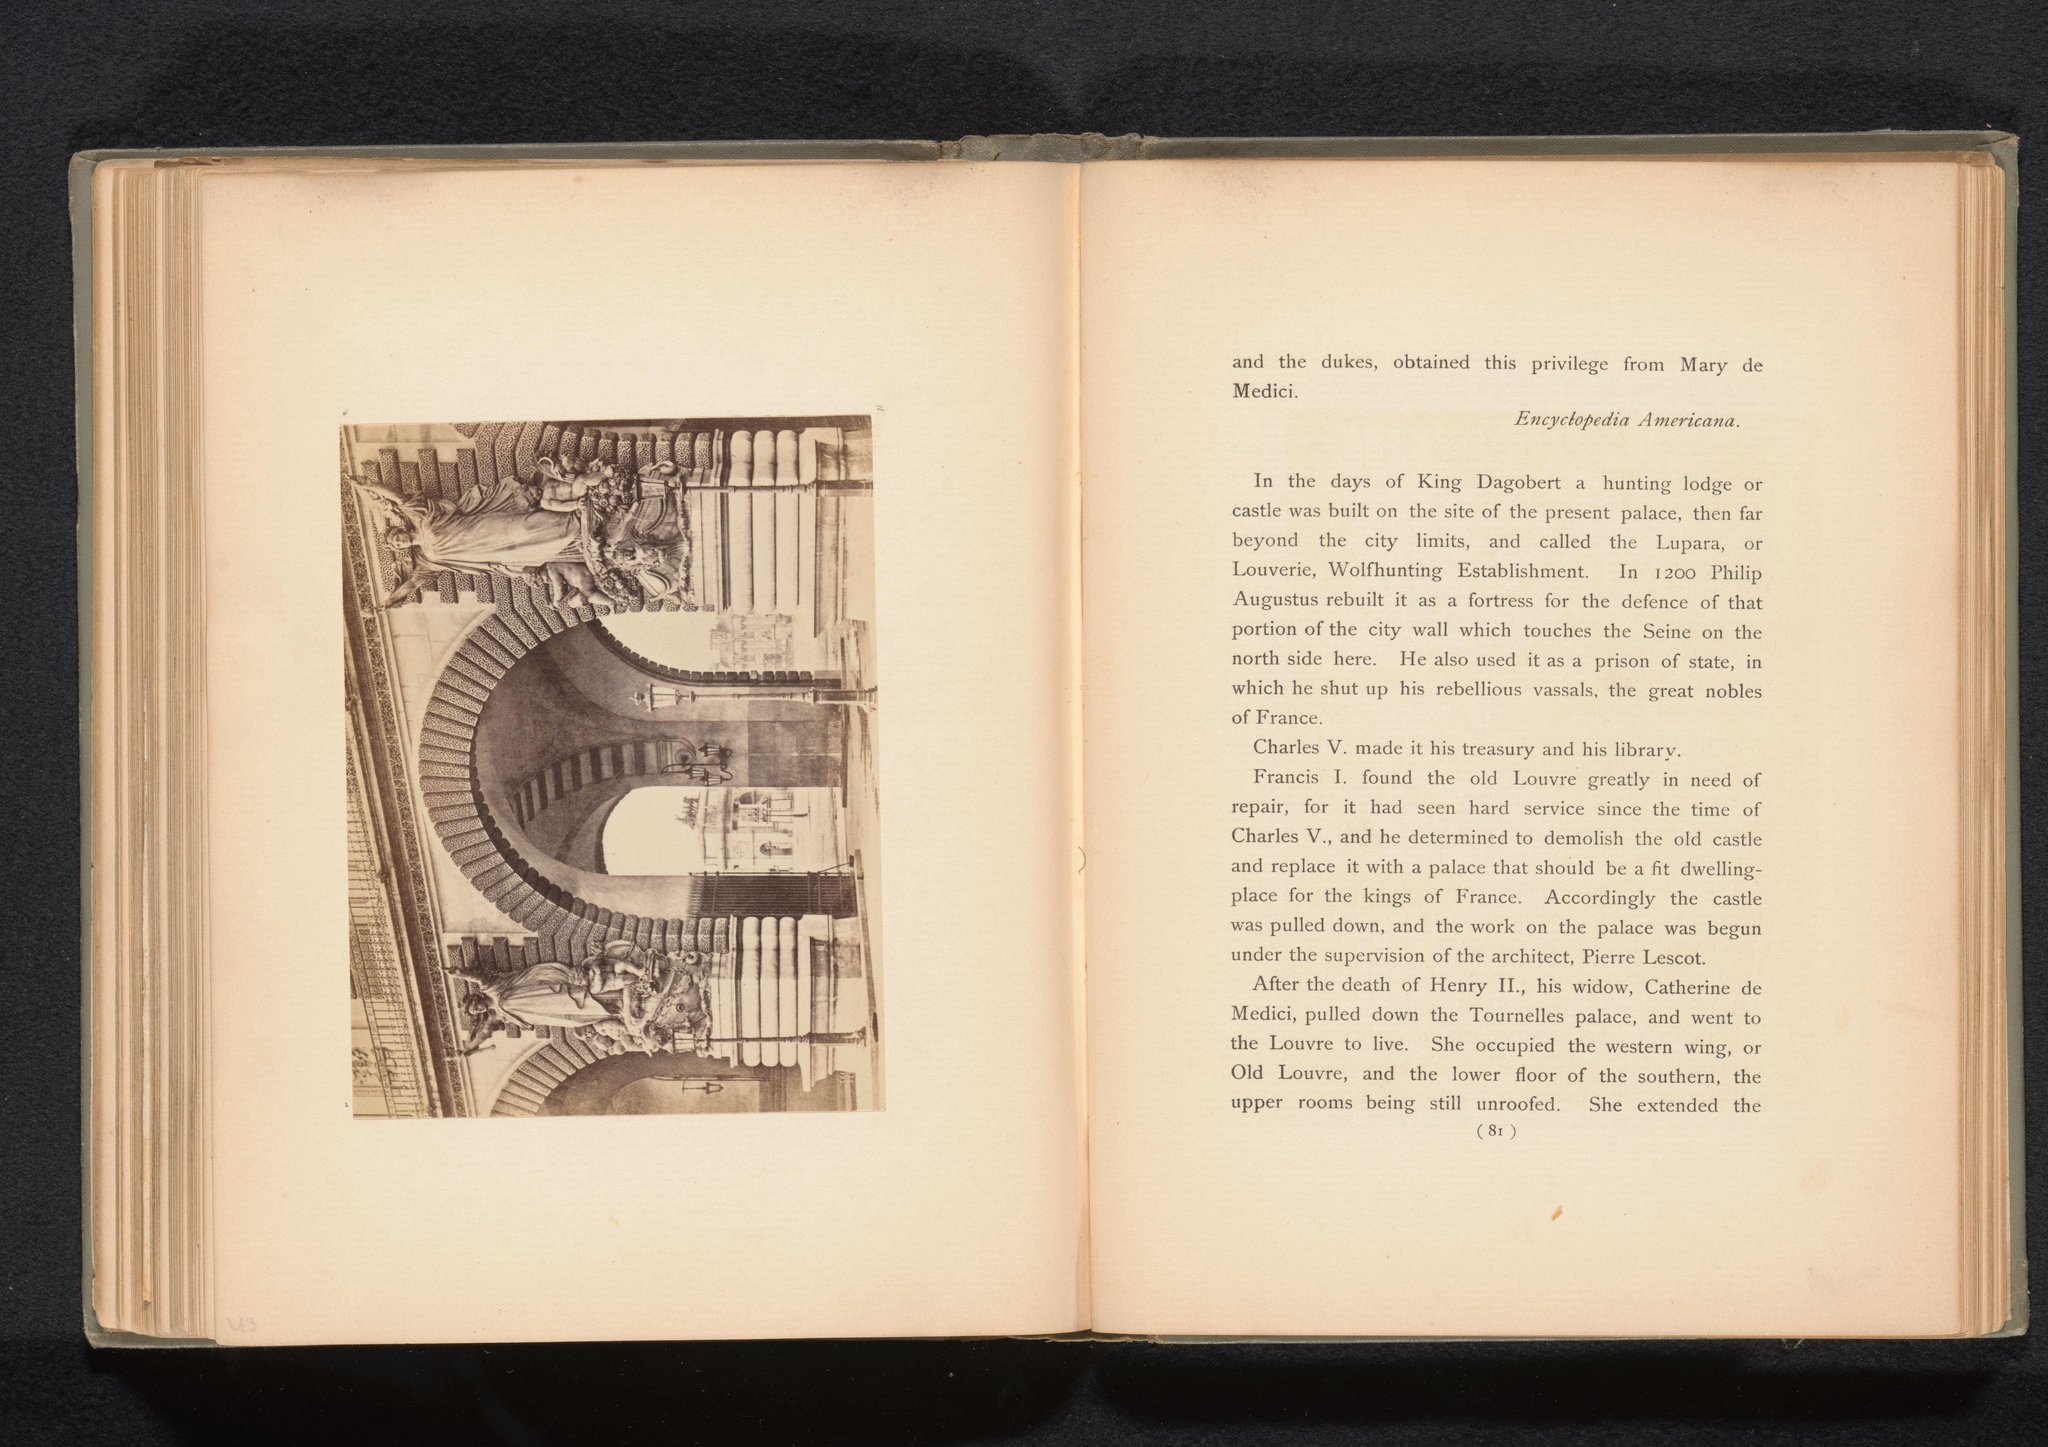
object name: page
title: Toegangsportaal van het Musée du Louvre te Parijs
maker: Anonymous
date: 1882-1887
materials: photographic support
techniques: albumen print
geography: paris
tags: permanent exhibition, museum, façade (of house or building)